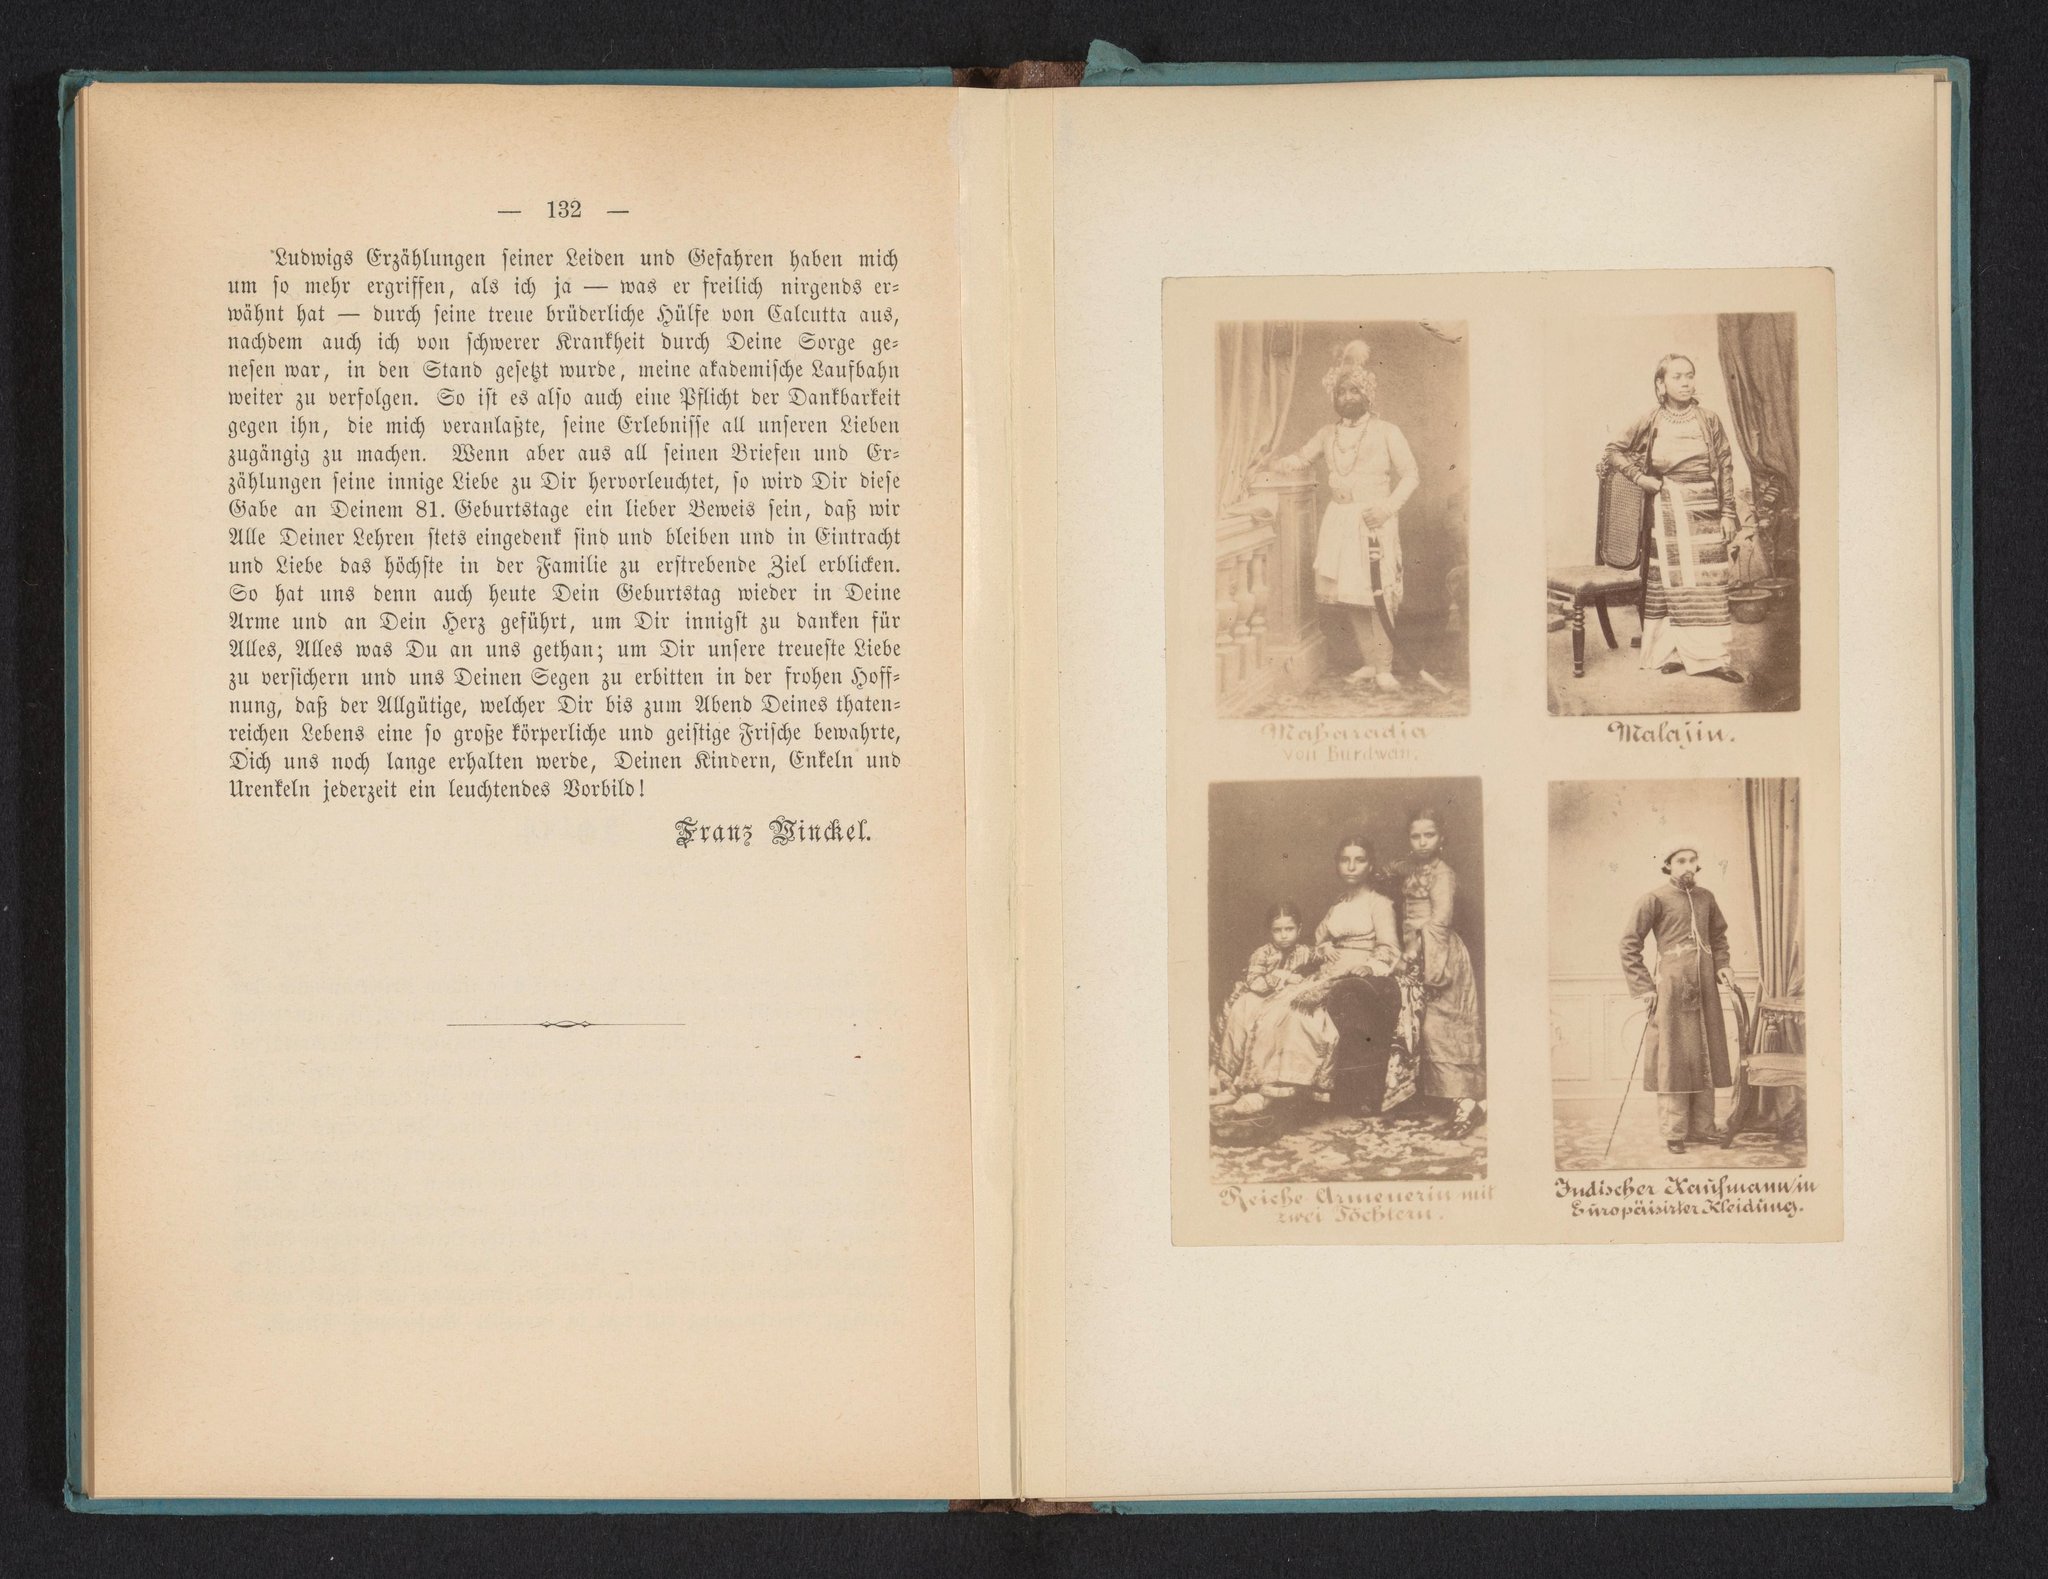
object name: page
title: Vier portretten van de maharadja van Bardhaman, een vrouw uit Malaju, een Armeense vrouw met haar twee dochters en een koopman uit India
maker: Anonymous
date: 1884-1889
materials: photographic support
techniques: albumen print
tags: adult woman, ruler, sovereign, mother and child(ren), woman and child(ren) (family group), merchant, salesman